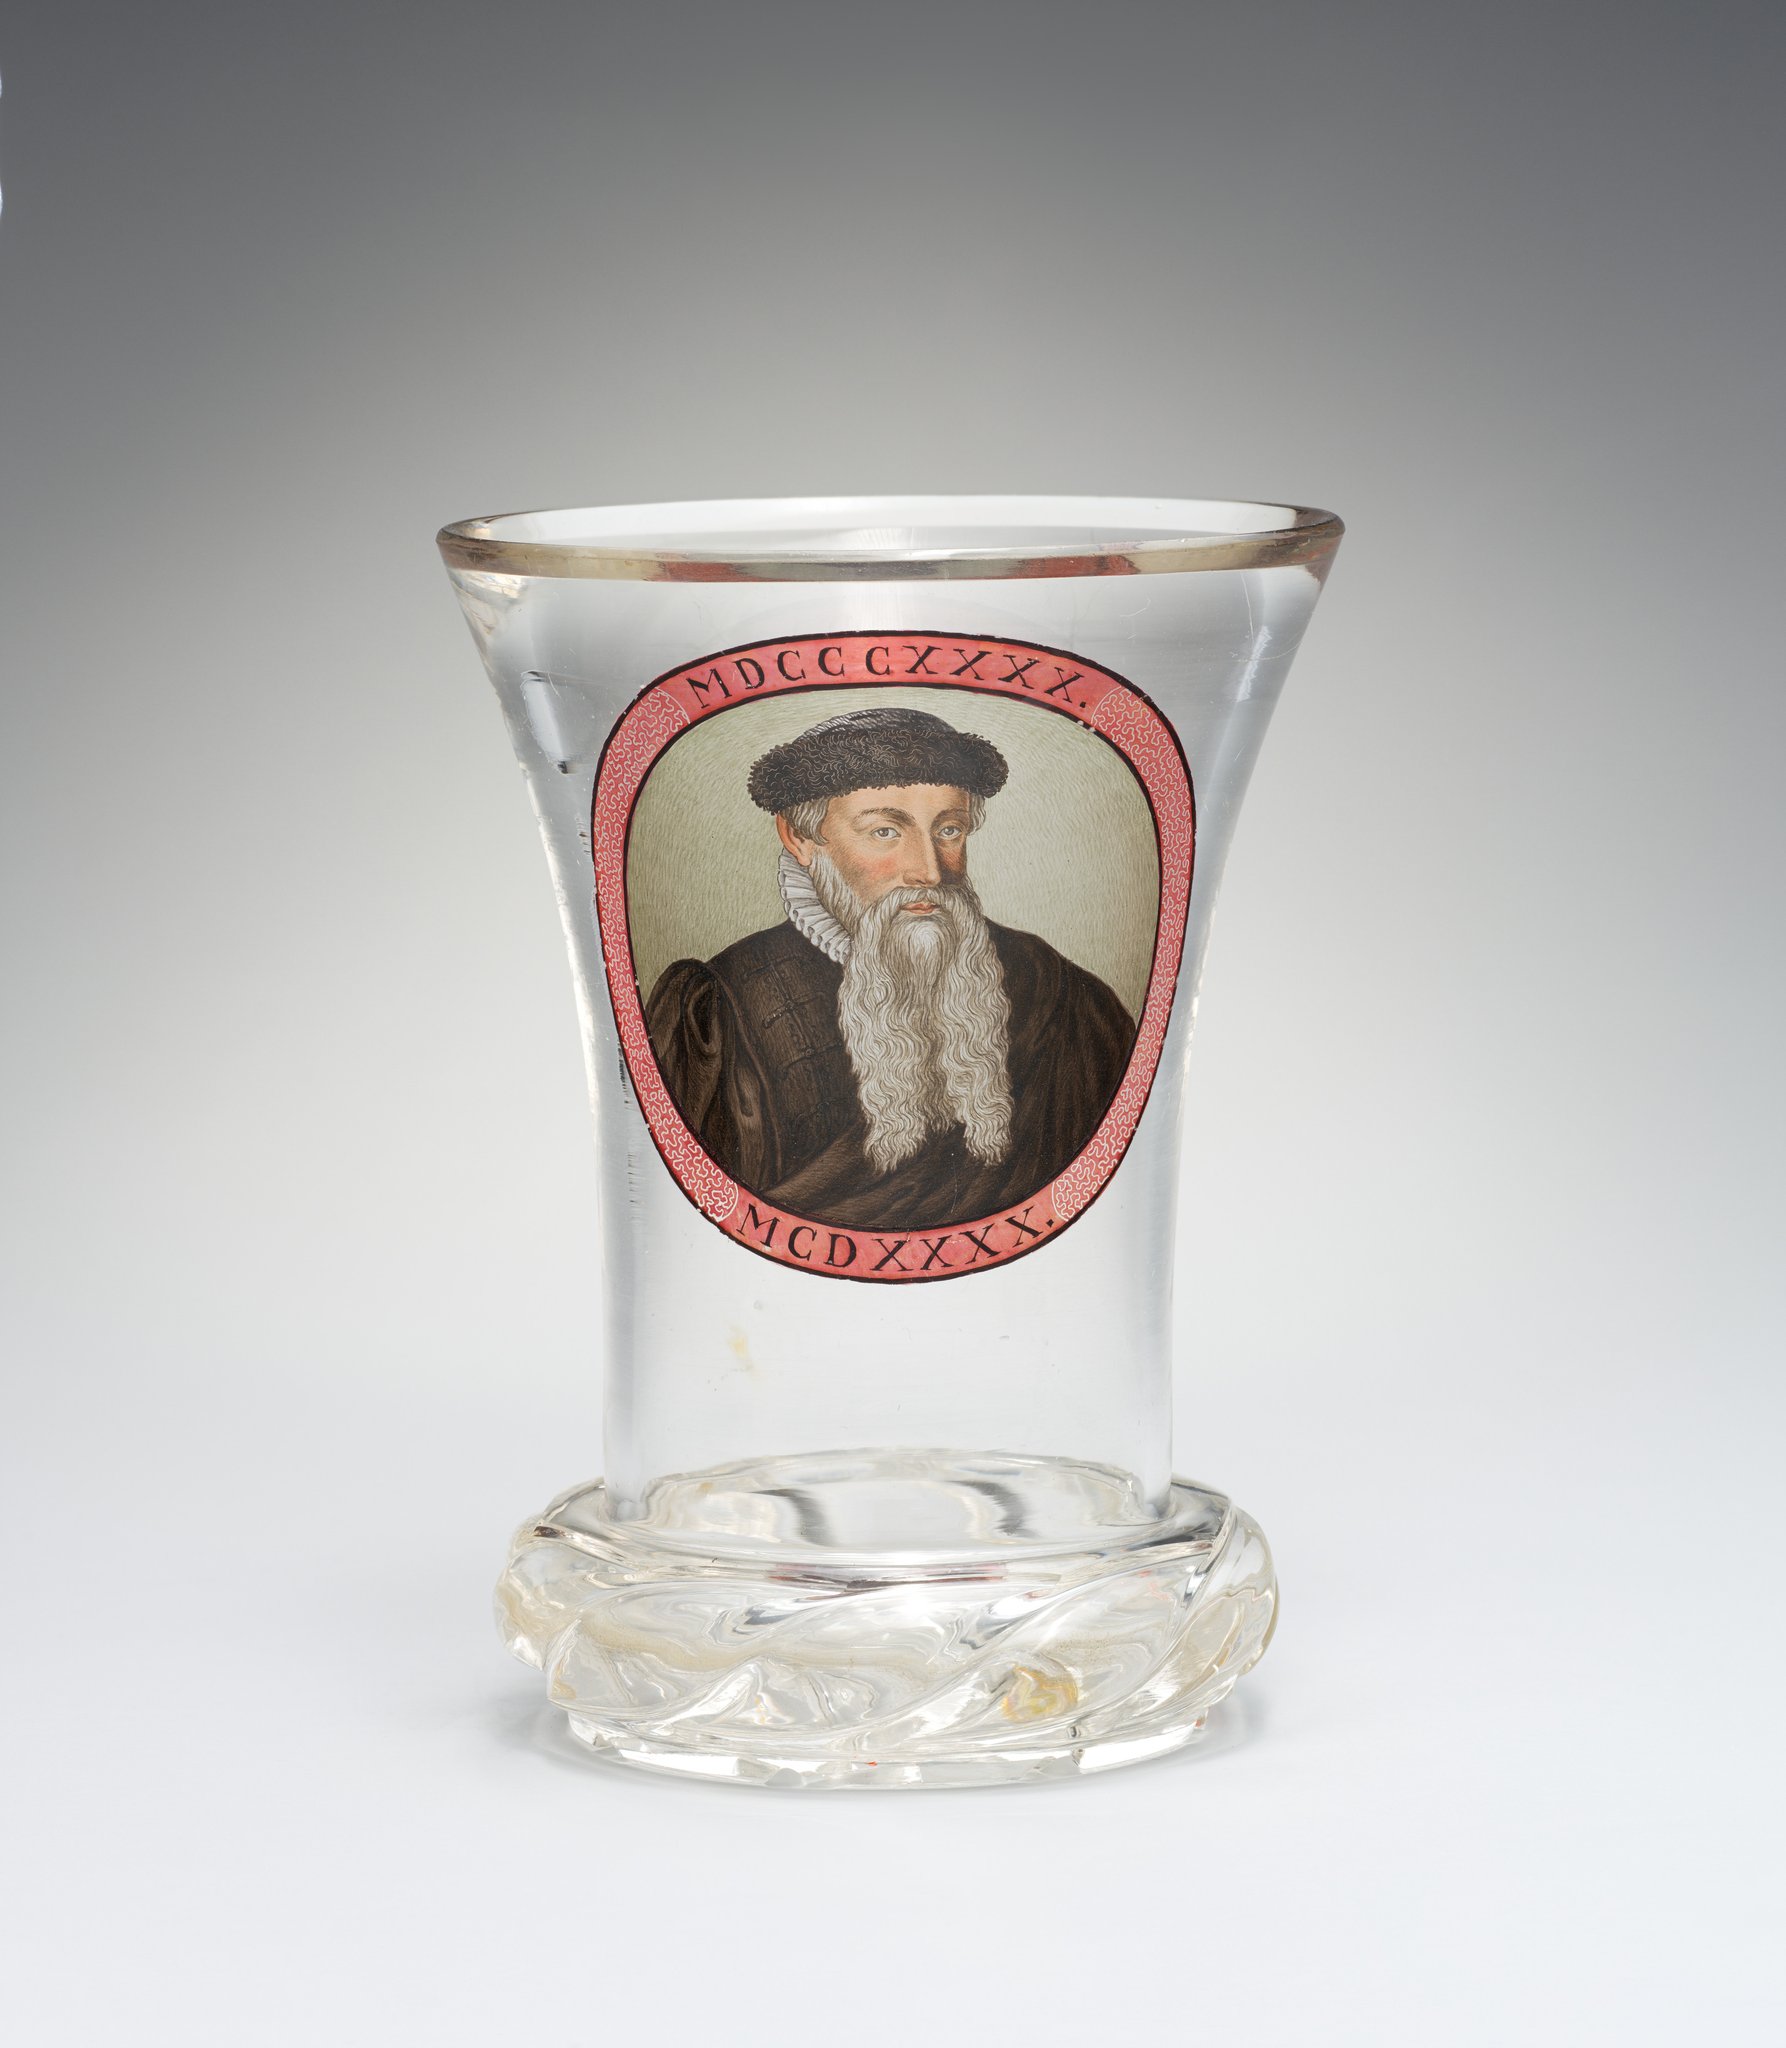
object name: beaker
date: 1801-1833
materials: glass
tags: men,portraits